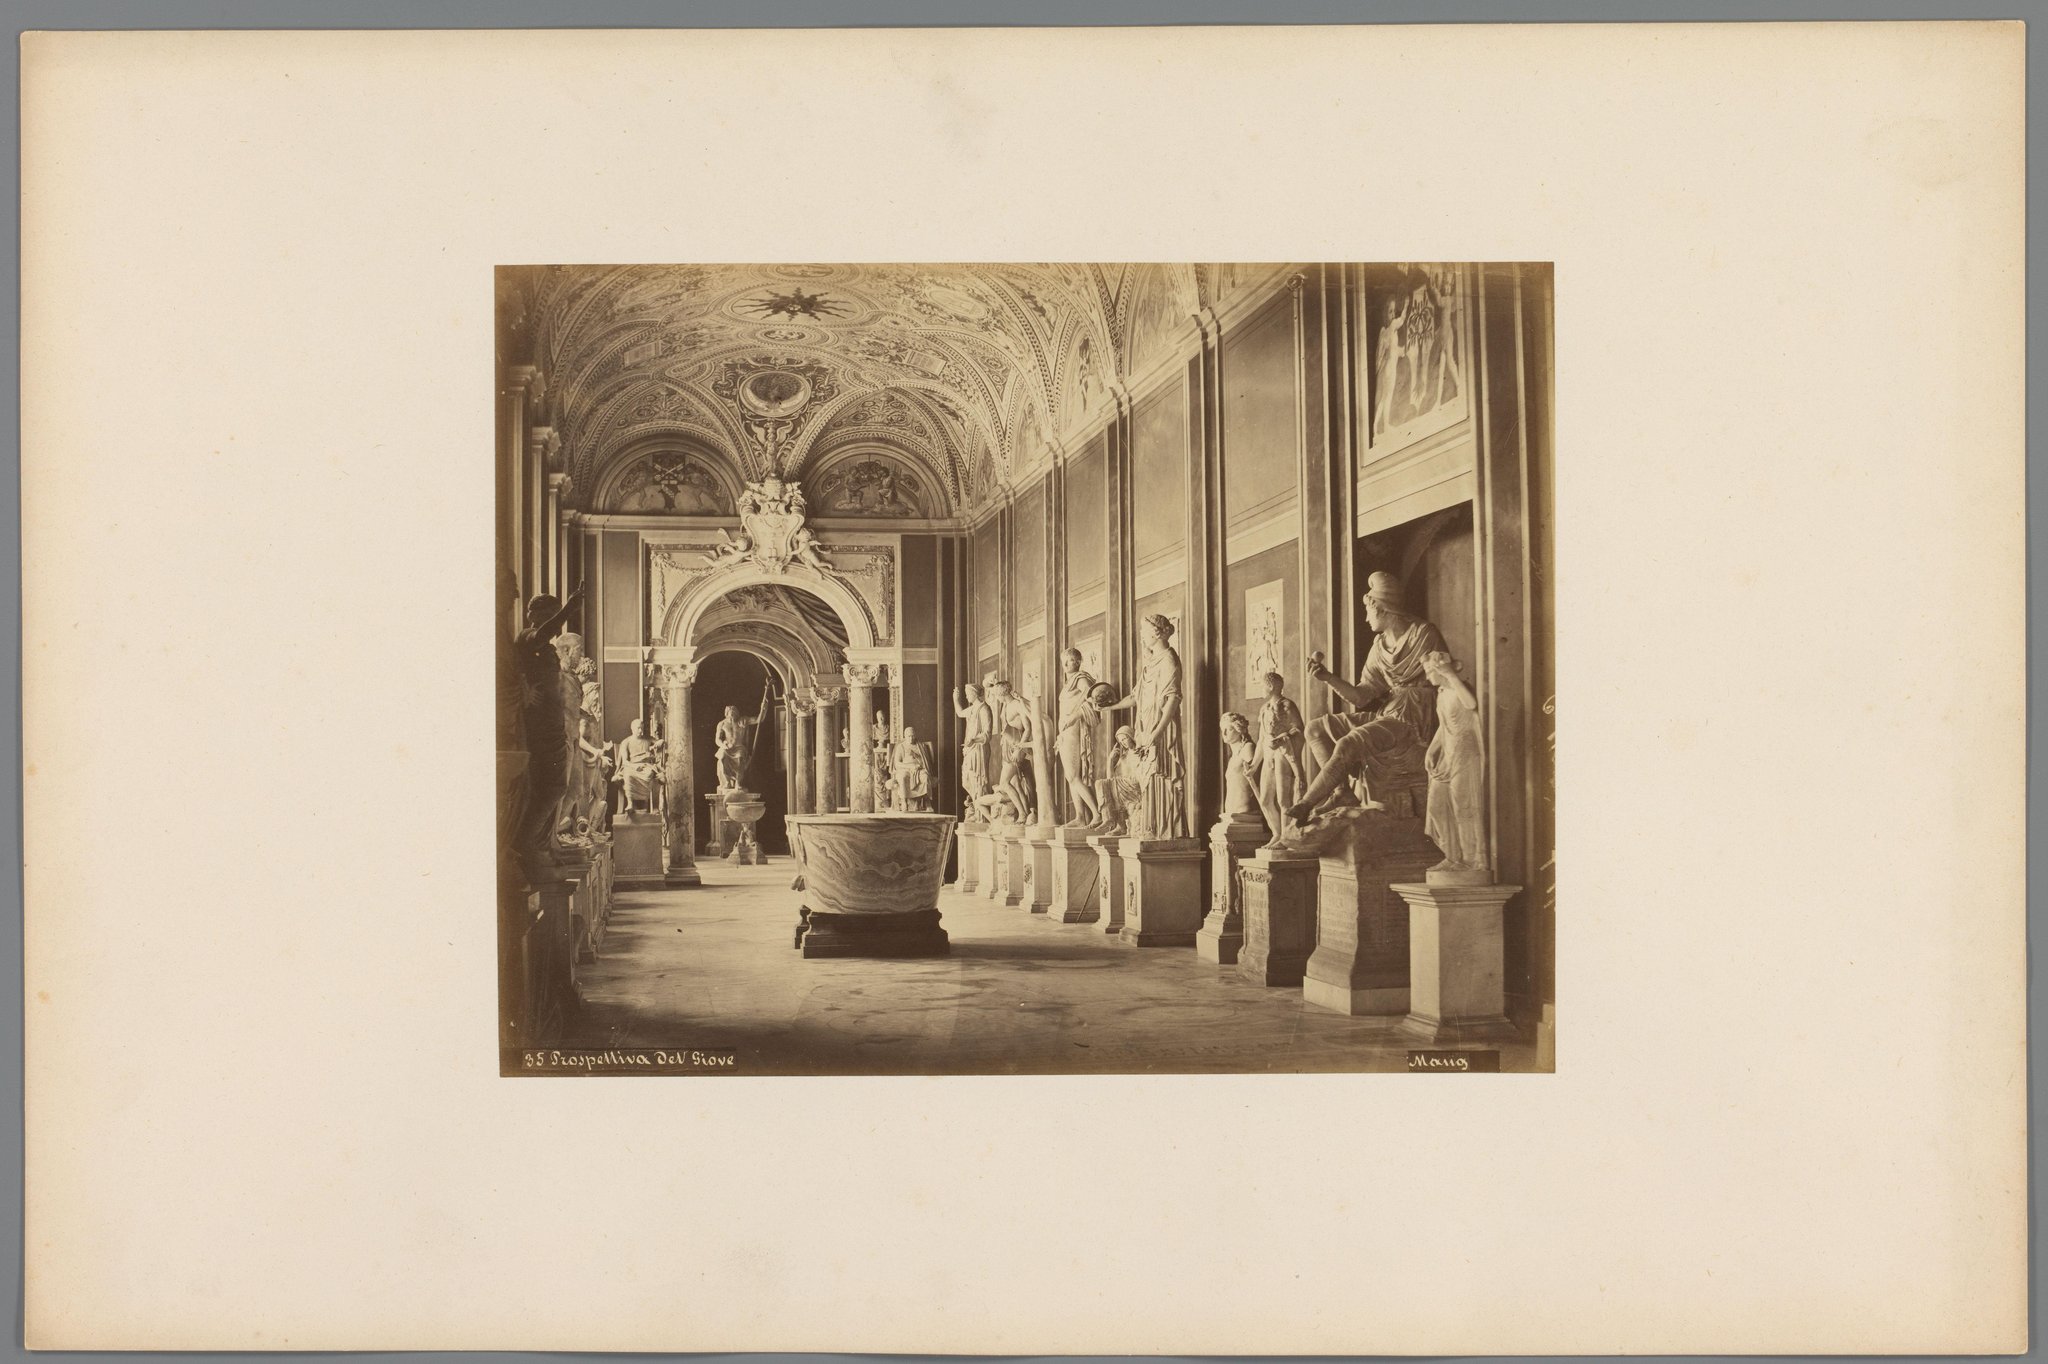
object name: photograph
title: Prospelliva del Siove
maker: michèle mang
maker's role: fotograaf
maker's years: 1840-1909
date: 1863-1887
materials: cardboard, paper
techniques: albumen print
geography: vatican city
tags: gallery of sculptures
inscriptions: number: ‘35’